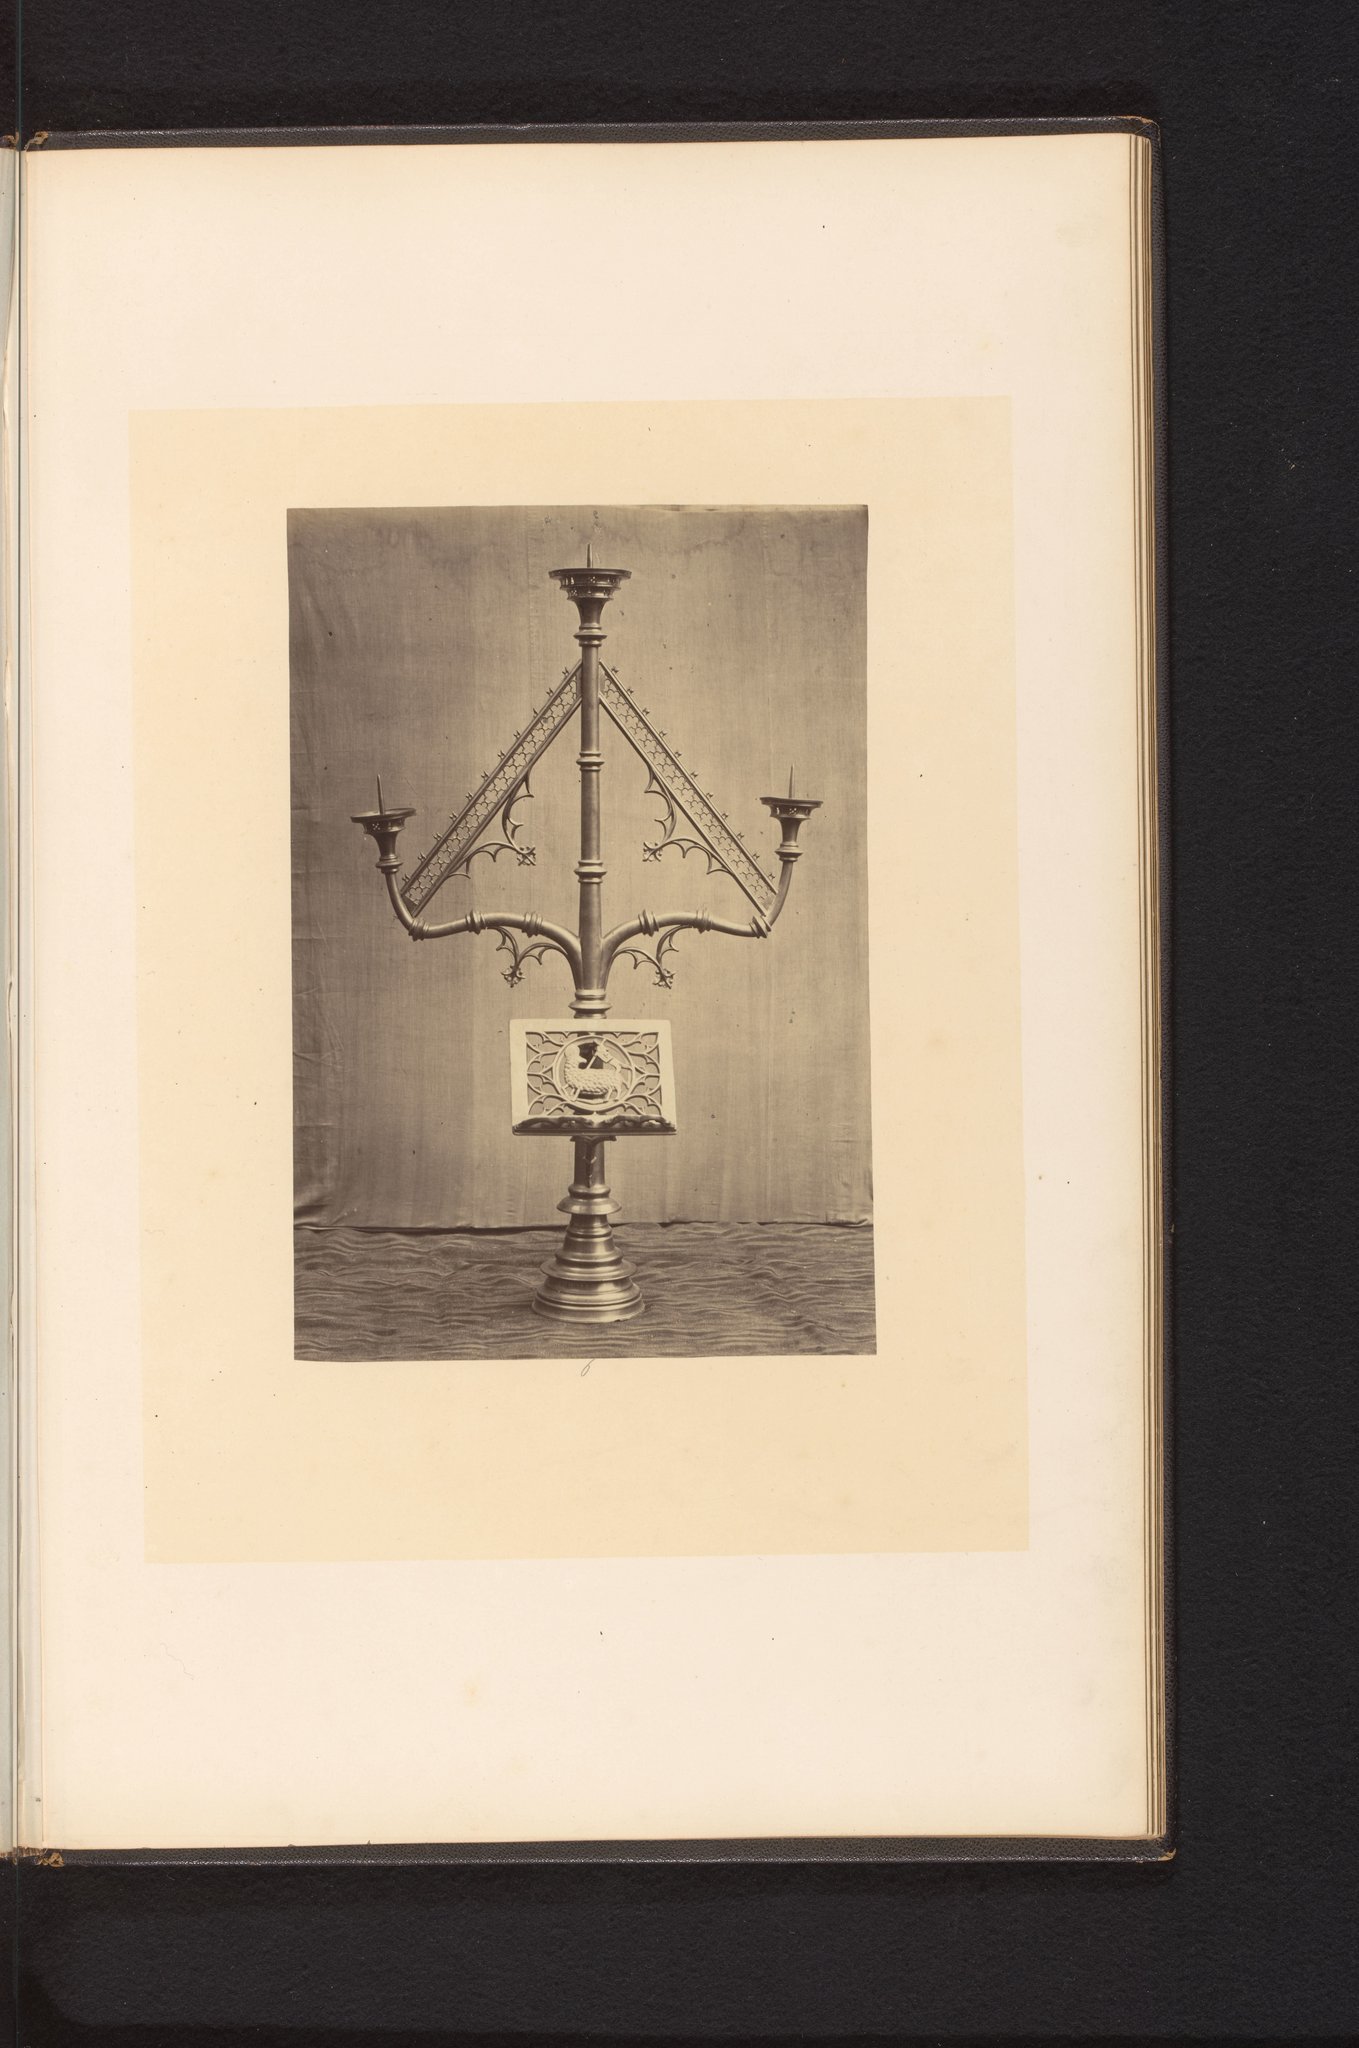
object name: page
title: Zeven metalen kandelaars, opgesteld op een tentoonstelling over religieuze objecten uit de middeleeuwen en renaissance in 1864 in Mechelen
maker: joseph maes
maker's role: fotograaf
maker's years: 1838-1908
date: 1864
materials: photographic support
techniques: albumen print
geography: mechelen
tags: altar accoutrement, candlestick, mechelen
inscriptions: number: ‘10 - 12 - 7 - 8 - 13 - 9 - 11’